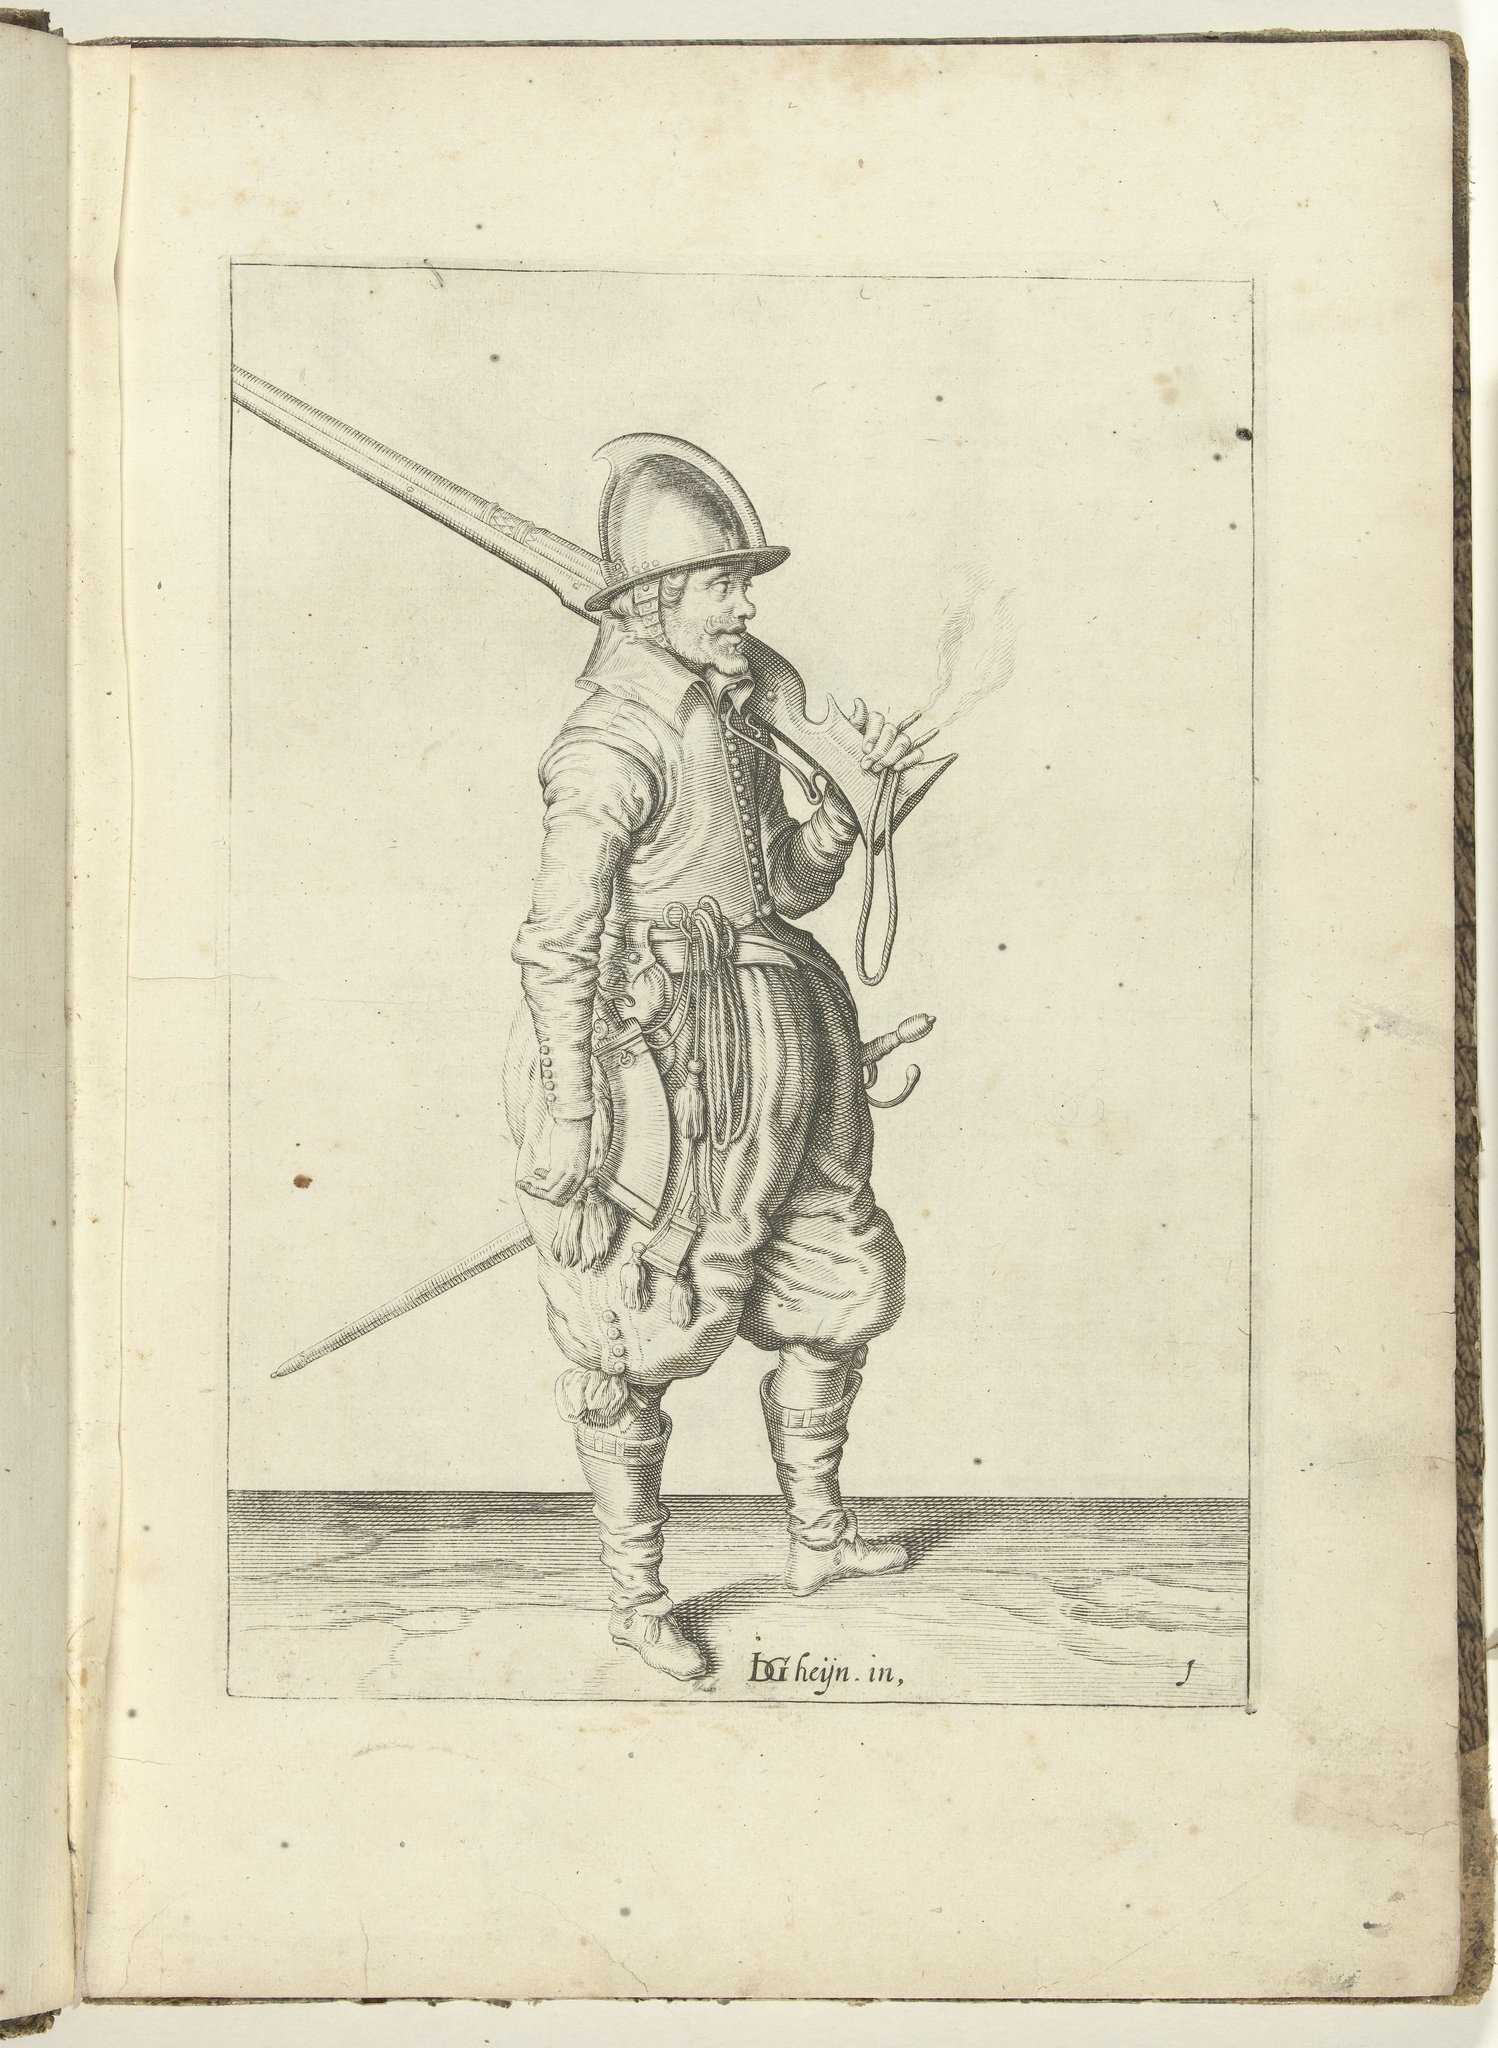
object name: print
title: Soldaat die zijn roer op zijn schouder draagt (nr. 1), ca. 1600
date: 1597-1608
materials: paper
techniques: engraving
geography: northern netherlands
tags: the hague, maurice (prince of orange), handling of weapons ~ military training, weapons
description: Een soldaat, ten voeten uit, naar rechts, met een roer (een bepaald type vuurwapen) steunend op zijn linkerschouder (nr. 1), ca. 1600. In zijn linkerhand behalve de kolf van het roer ook een brandende lont. Plaat 1 in de instructies voor het hanteren van de roer: Brief enseignement, sur la representation des figures, du droit maniement de l'Harquebuse. Onderdeel van de illustraties in een Franse editie van J. de Gheyns Wapenhandelinghe: J. de Gheyn, Maniement d'armes, d'arquebuses, mousquetz et piques : en conformité de l'ordre de Mour le Prince Maurice, Prince d'Orange, Amsterdam 1608. Krijgswezen rond 1600.